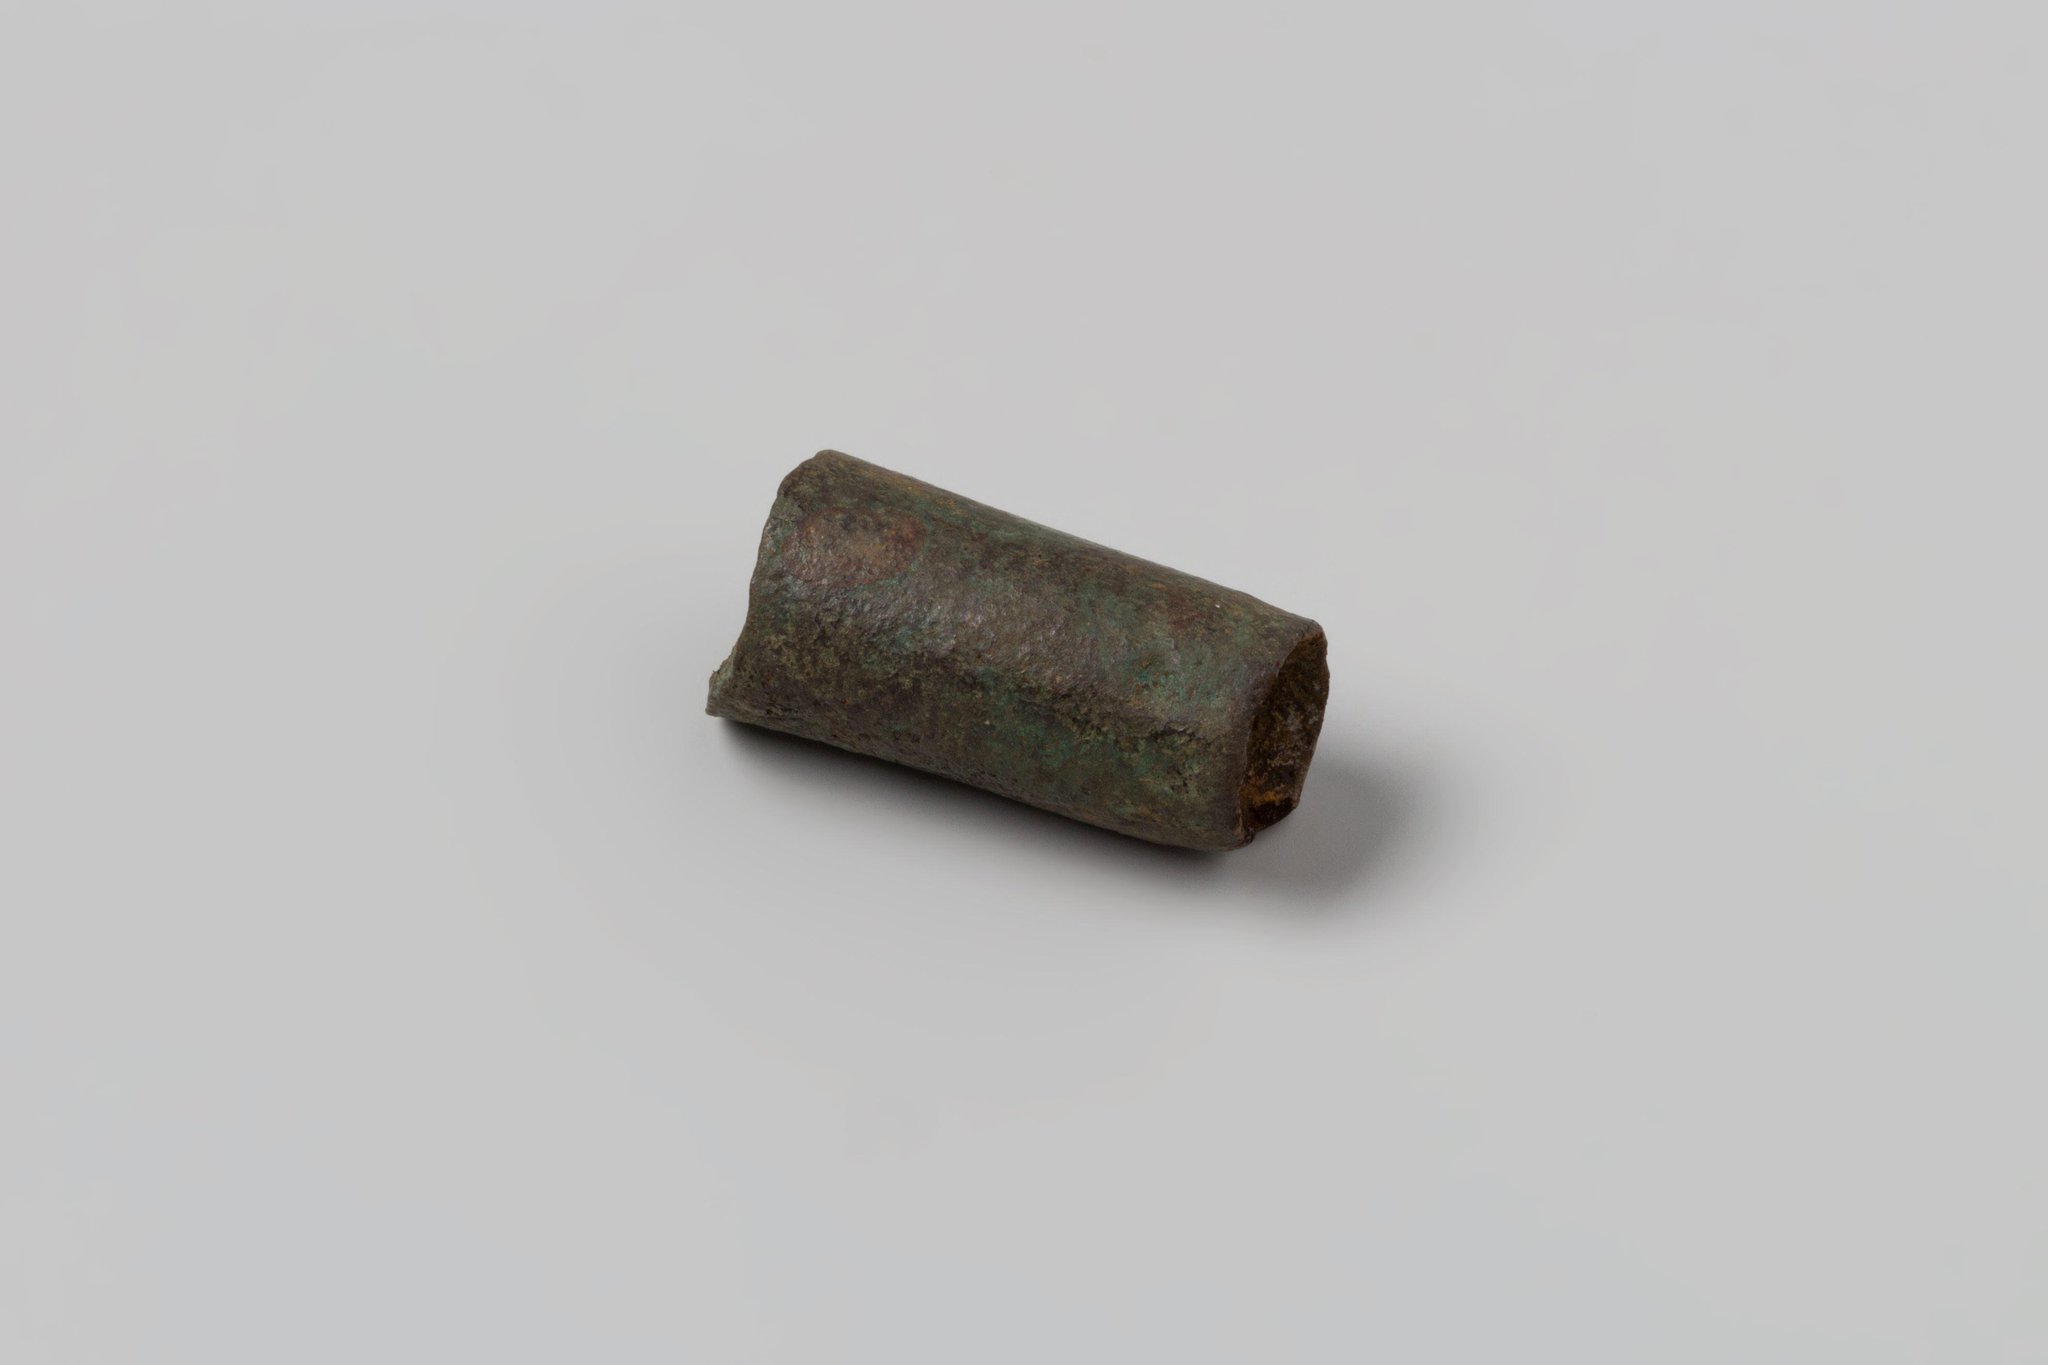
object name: spigot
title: Fragment kraan uit het wrak van de Oost-Indiëvaarder Hollandia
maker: Anonymous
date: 1700-1743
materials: copper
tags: verenigde oostindische compagnie, hollandia (schip), annet